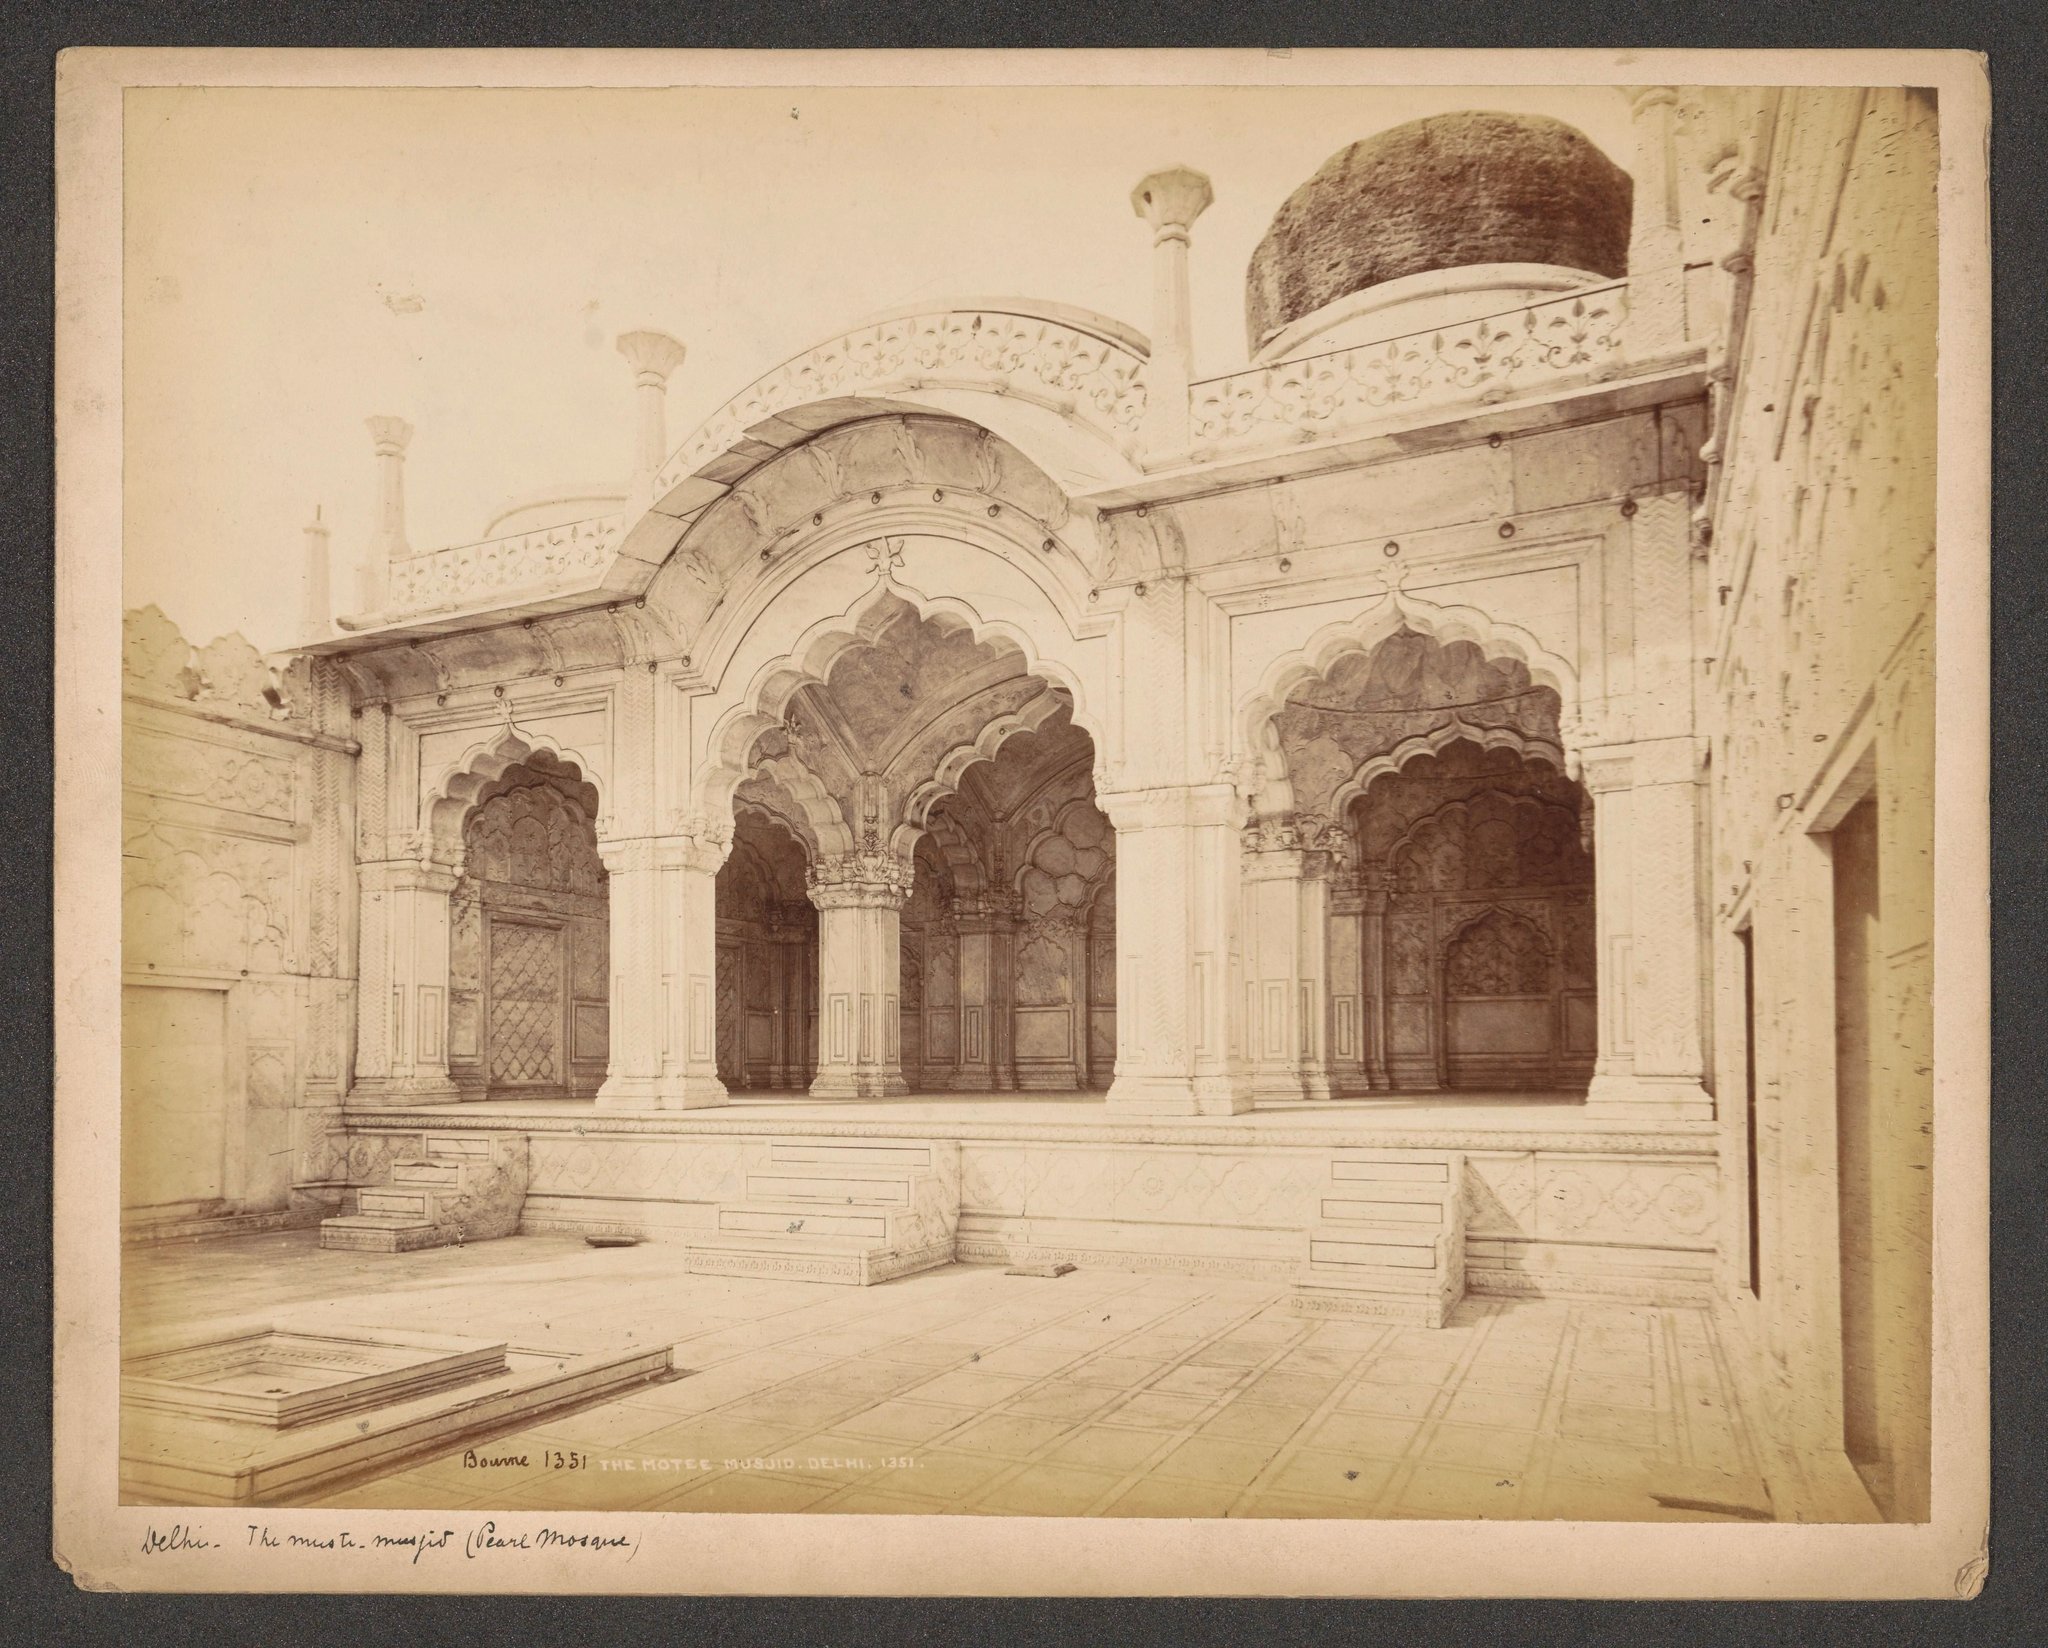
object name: photograph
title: View of the entrance of the Moti Masjid in the Red Fort at Delhi, India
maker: samuel bourne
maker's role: fotograaf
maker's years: 1834-1912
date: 1863-1866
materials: cardboard, paper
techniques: albumen print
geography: delhi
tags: temple, shrine ~ islam, mohammedanism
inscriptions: number: ‘27’, name: ‘Bourne’, title: ‘The Motee Musjid. Delhi.’, number: ‘1351/ 1351’, inscription: ‘Delhi - The Musti-Musjid (Pearl Mosque)’